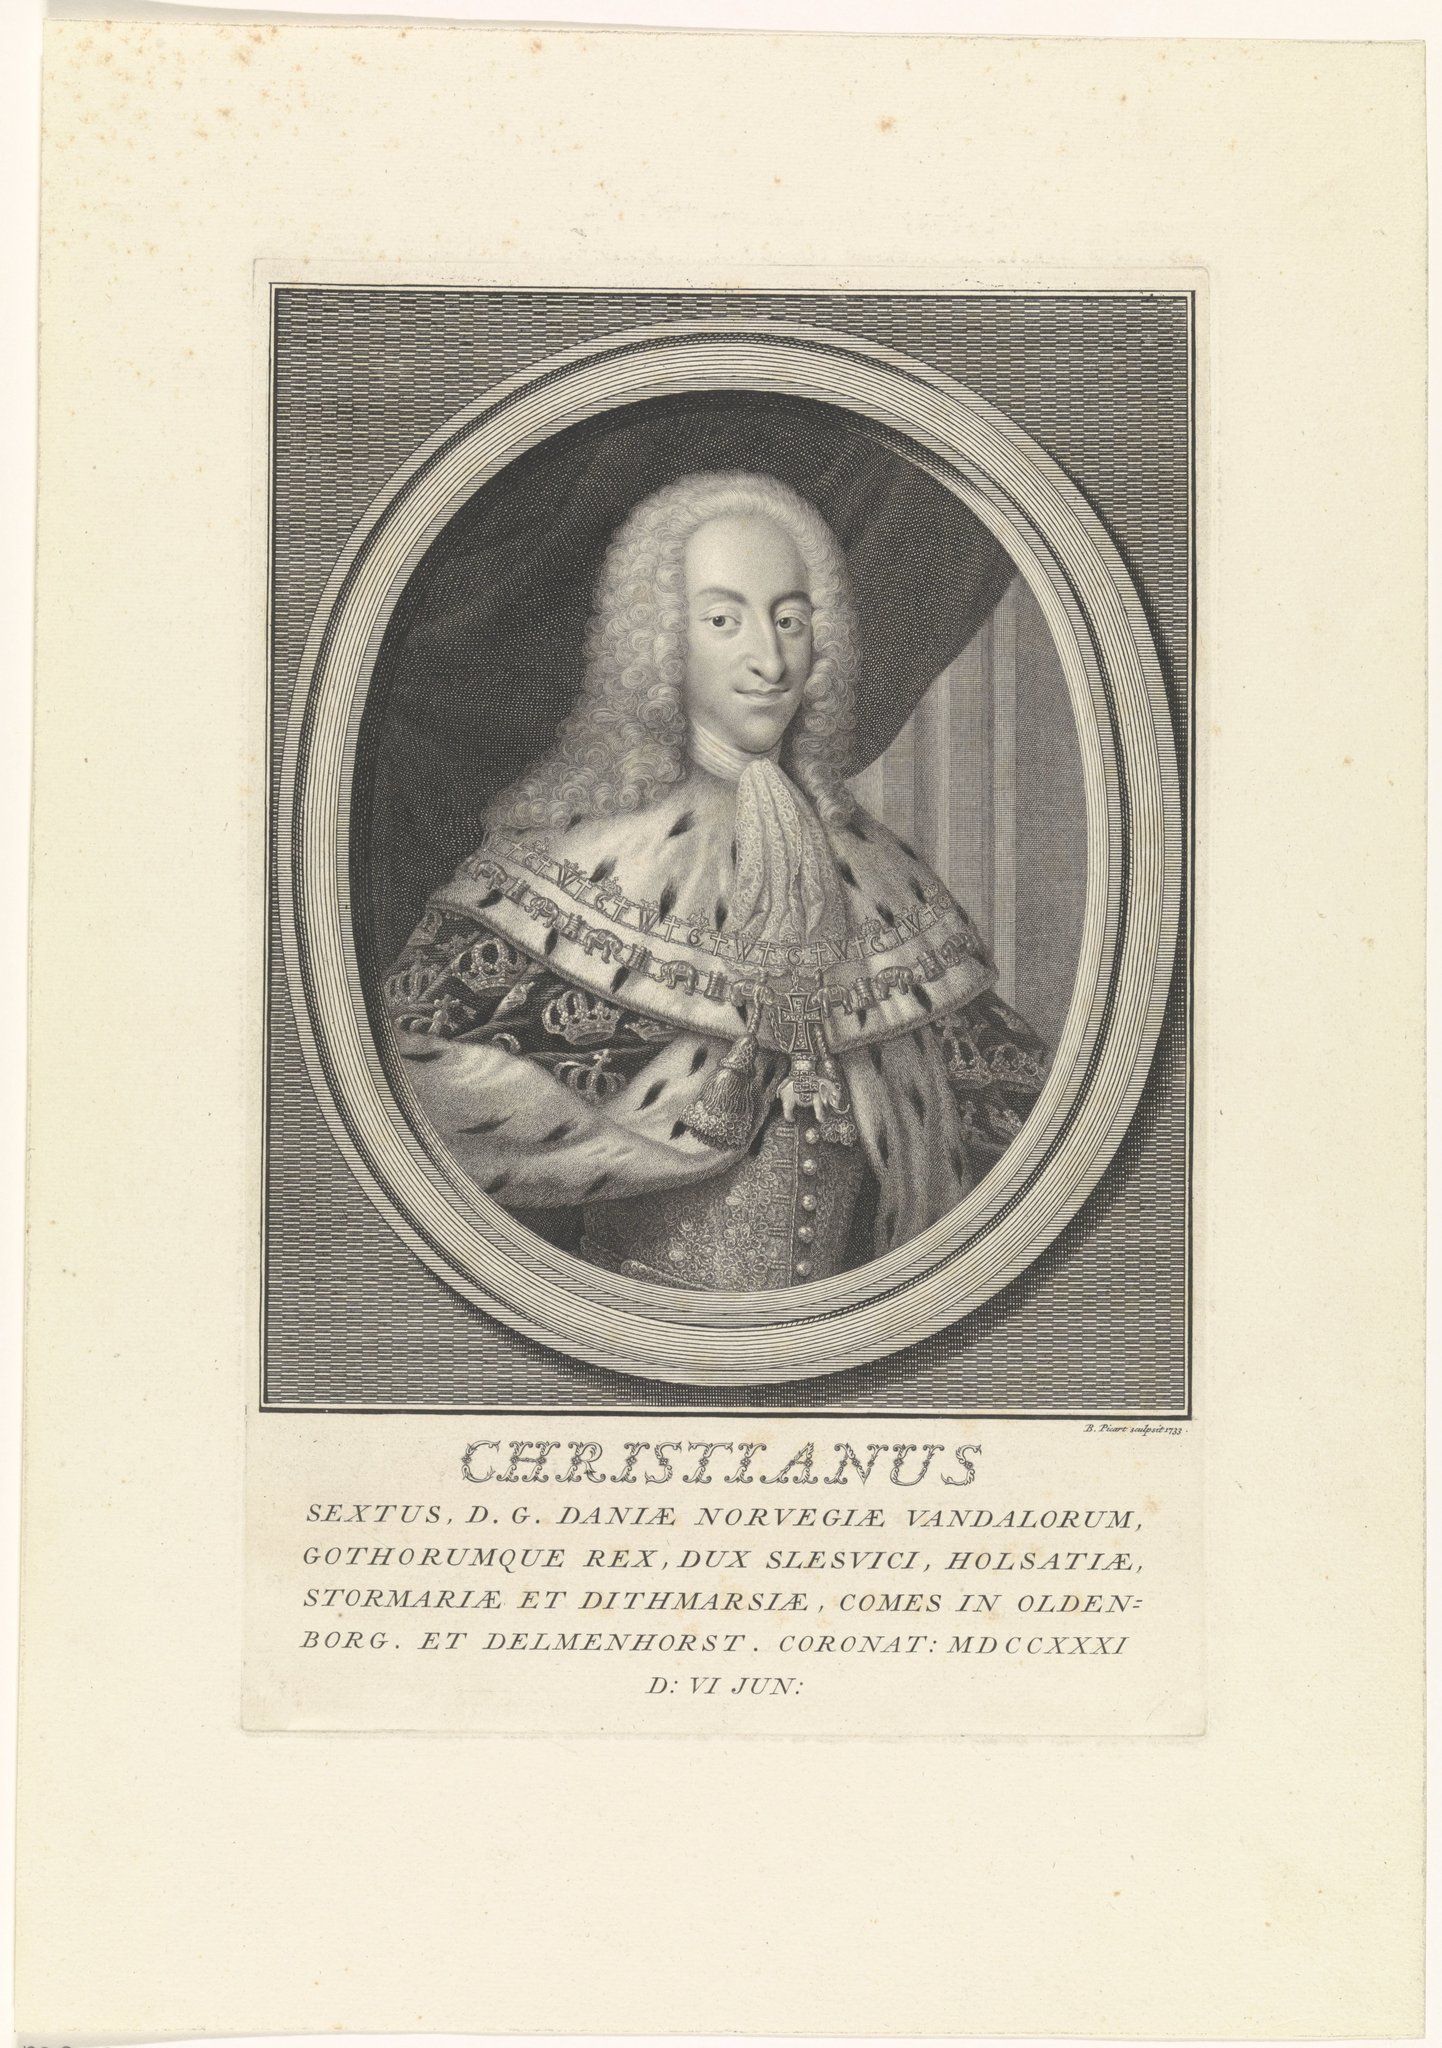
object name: print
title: Portret van Christiaan VI van Denemarken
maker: bernard picart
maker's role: draughtsman, print maker, publisher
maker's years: 1673-1733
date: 1733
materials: paper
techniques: engraving, etching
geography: amsterdam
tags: copenhagen (city), knighthood order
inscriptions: collector's mark: Lugt 240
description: Portret van Christiaan VI, koning van Denemarken en Noorwegen. Hij draagt een keten met de Orde van de Olifant. In de marge een vijfregelig onderschrift in het Latijn.